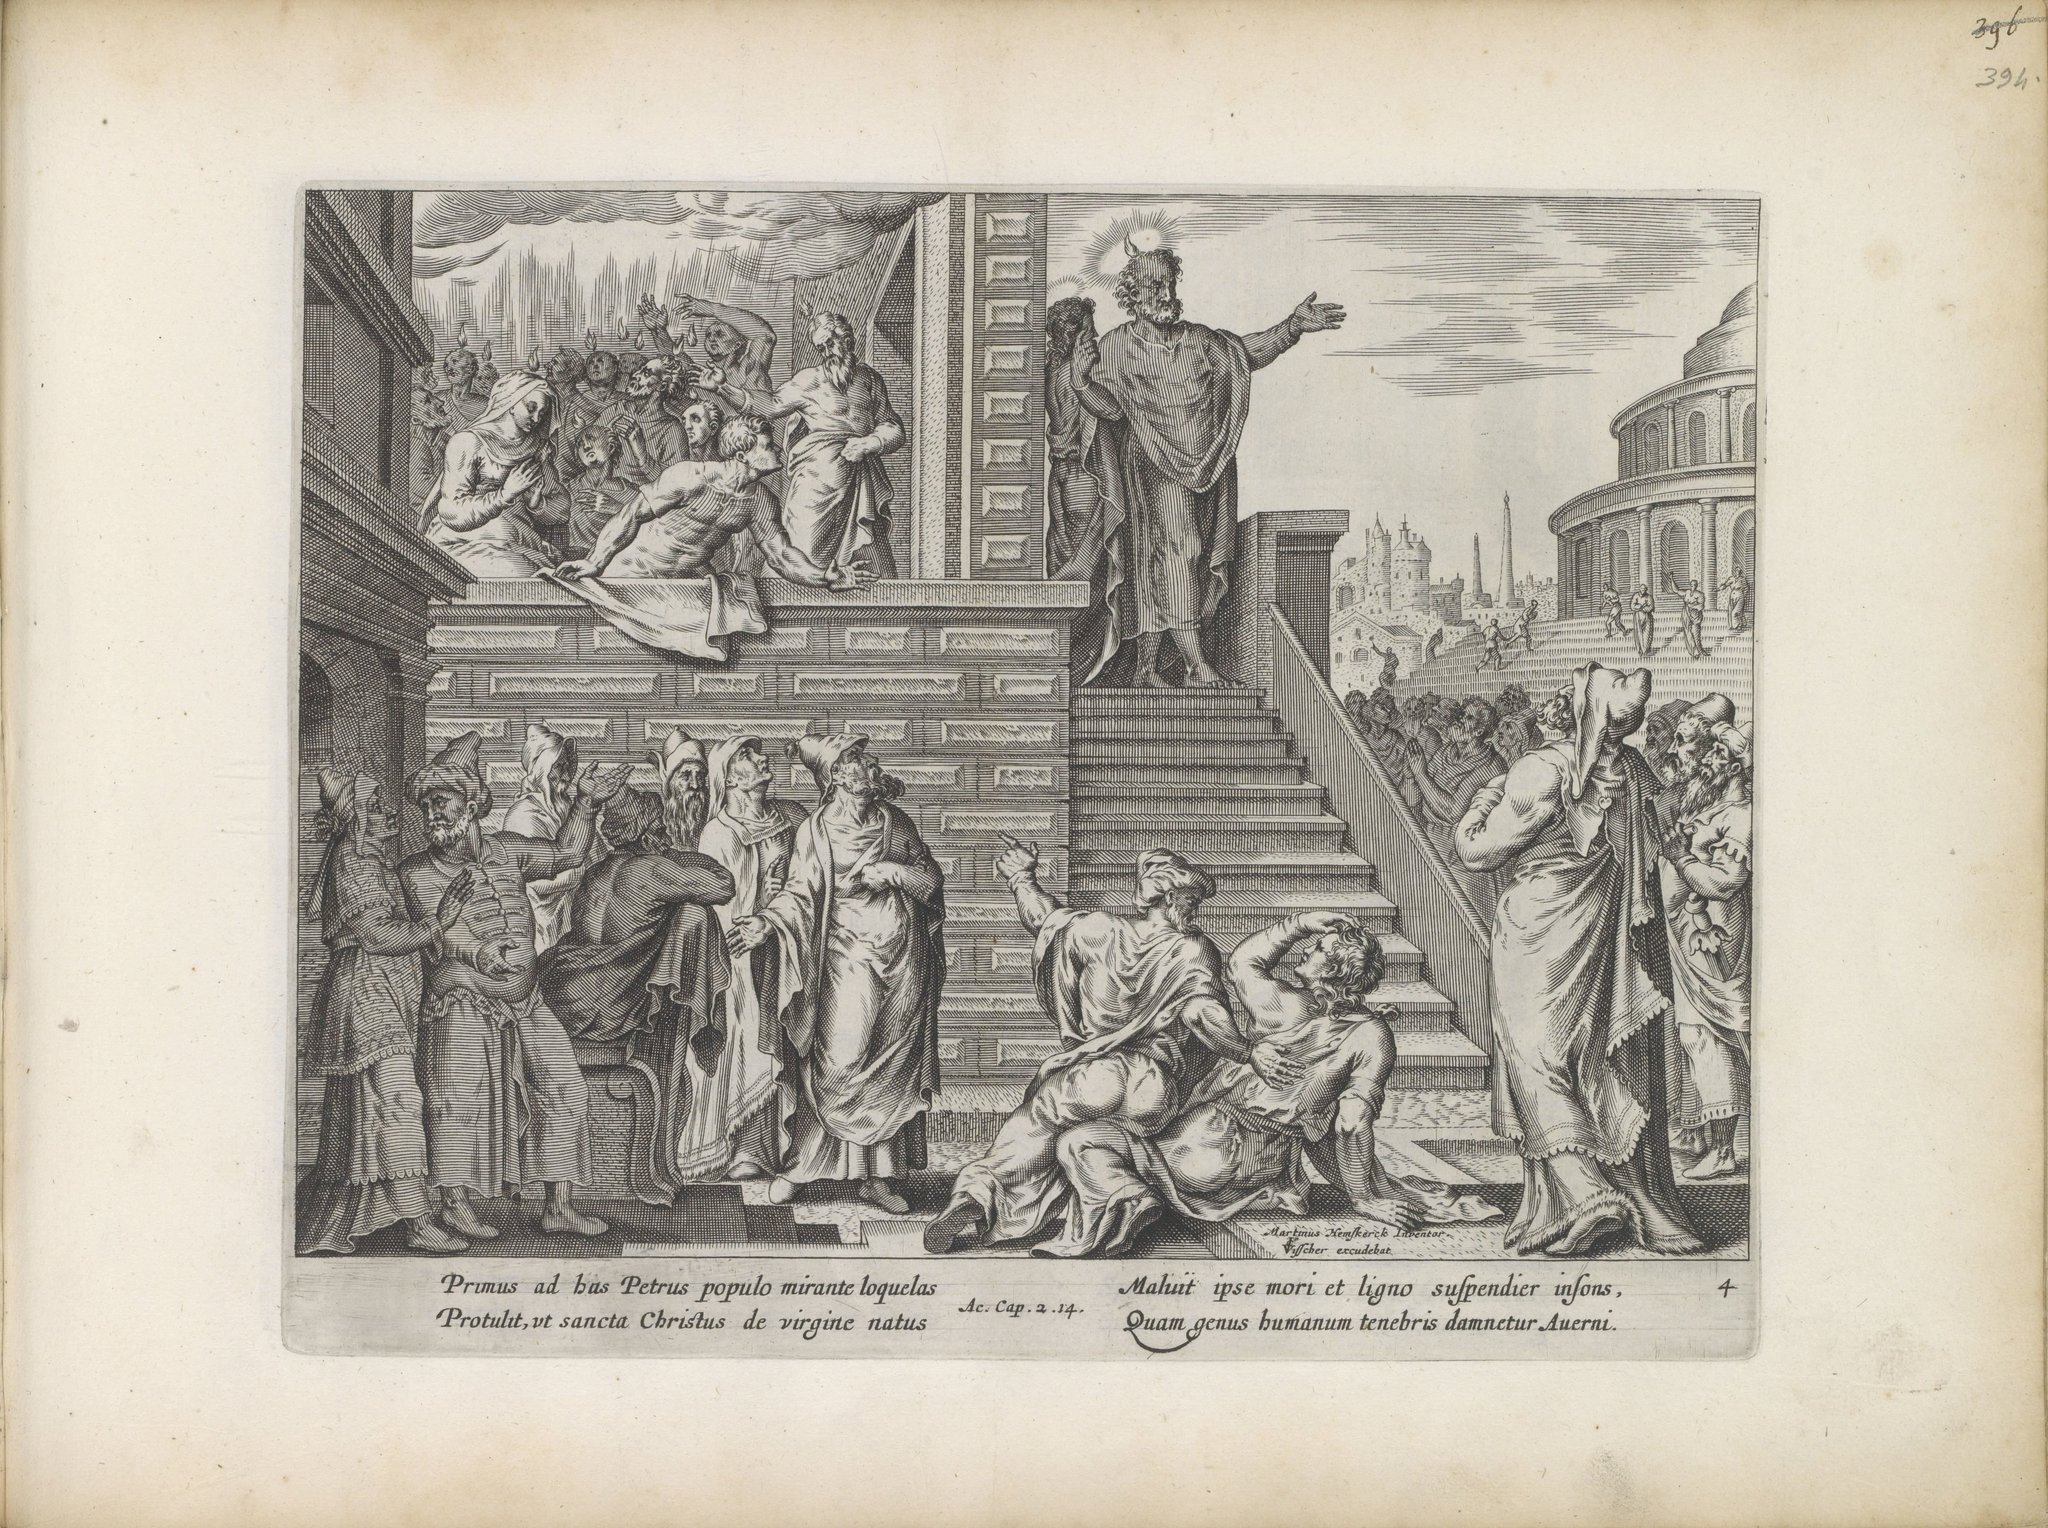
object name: album leaf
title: Petrus preekt in Jeruzalem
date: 1643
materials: paper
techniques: engraving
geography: amsterdam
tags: peter delivers a sermon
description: De heilige Geest daalt neer op Maria en de apostelen, die bijeen zijn in een bovenzaal. De apostel Petrus staat buiten het huis en verkondigt de boodschap van Christus. Onder de voorstelling een verwijzing in het Latijn naar de Bijbeltekst in Hand. 2:14. Deze prent maakt deel uit van een album.